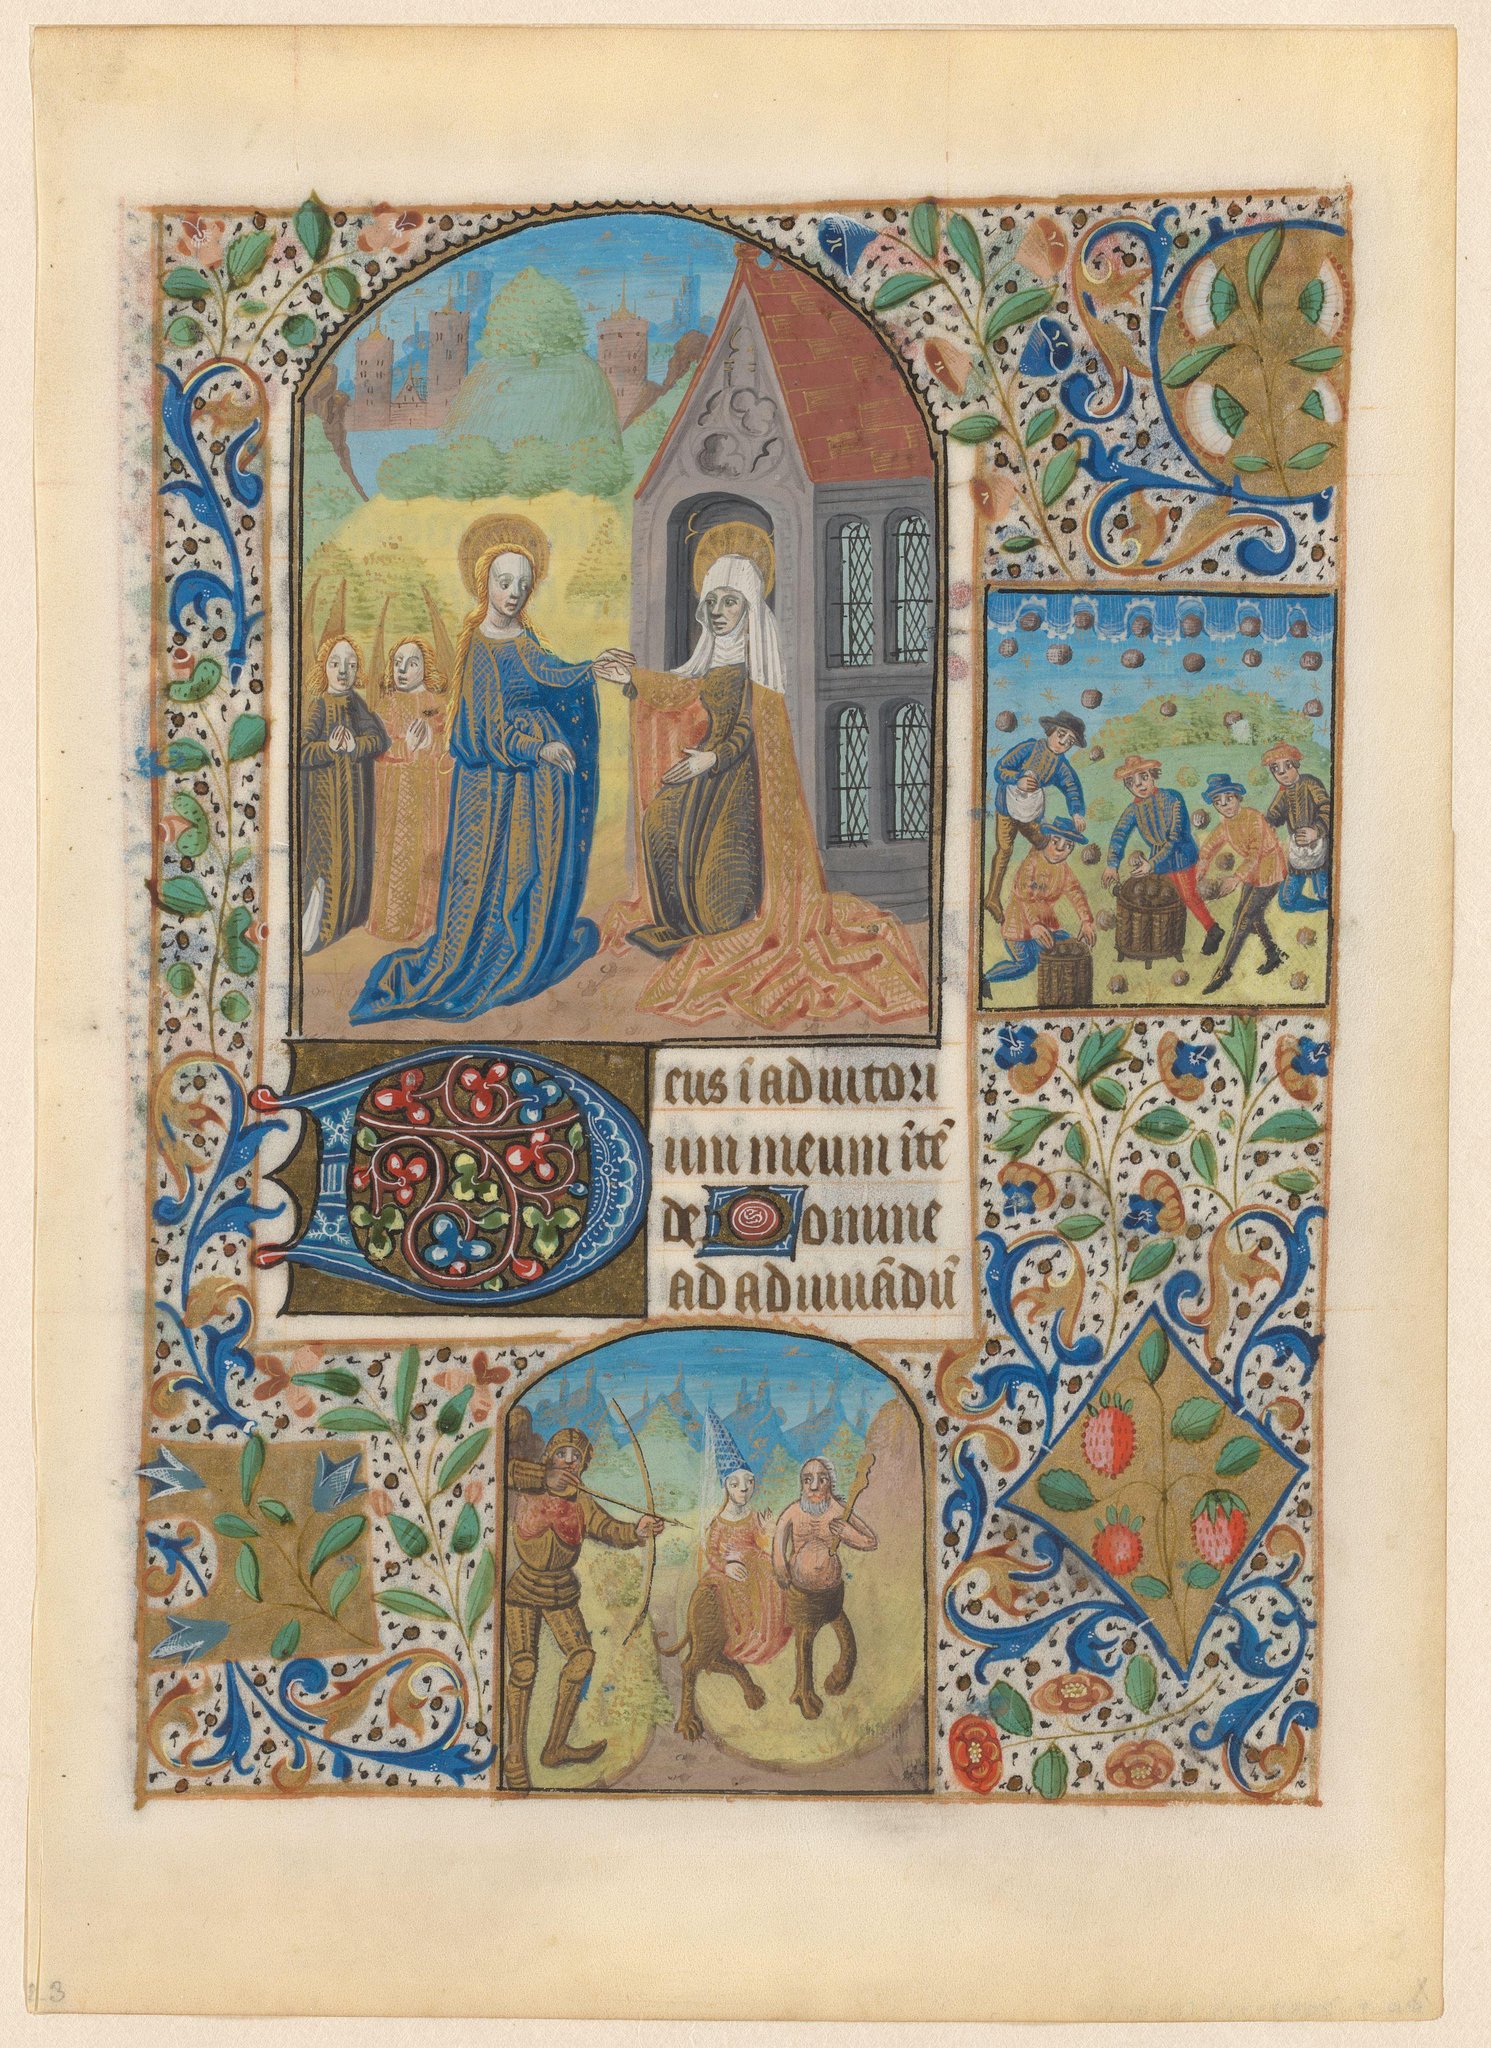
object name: manuscript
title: Blad uit een getijdenboek met volbladminiatuur van de Visitatie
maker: Anonymous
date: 1550-1599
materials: paint, gold leaf, ink, parchment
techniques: brush, pen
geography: northern france